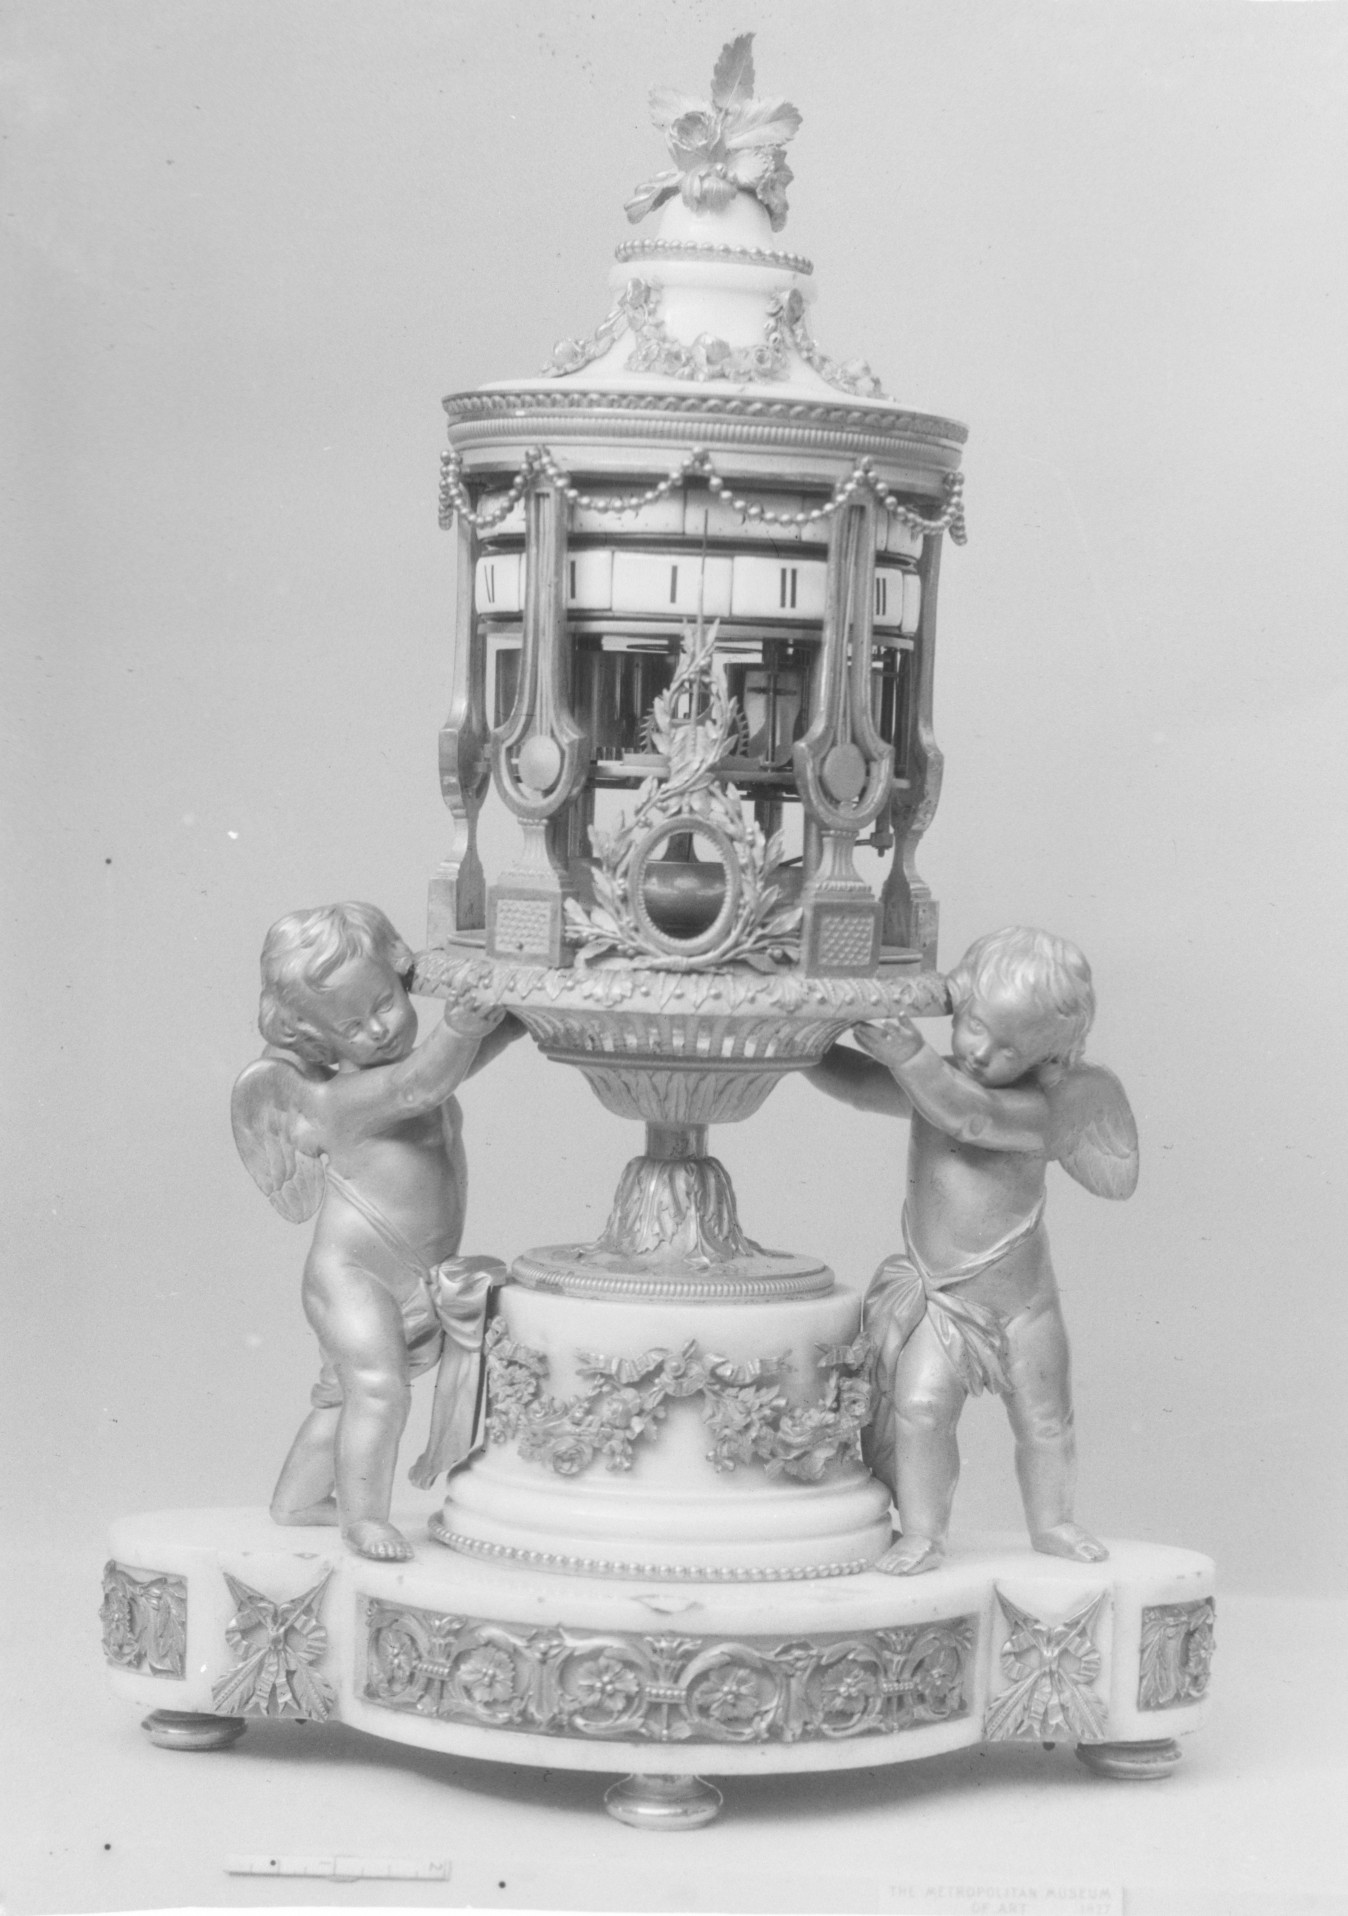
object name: clock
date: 1785-1790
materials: gilt bronze, marble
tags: roses,angels